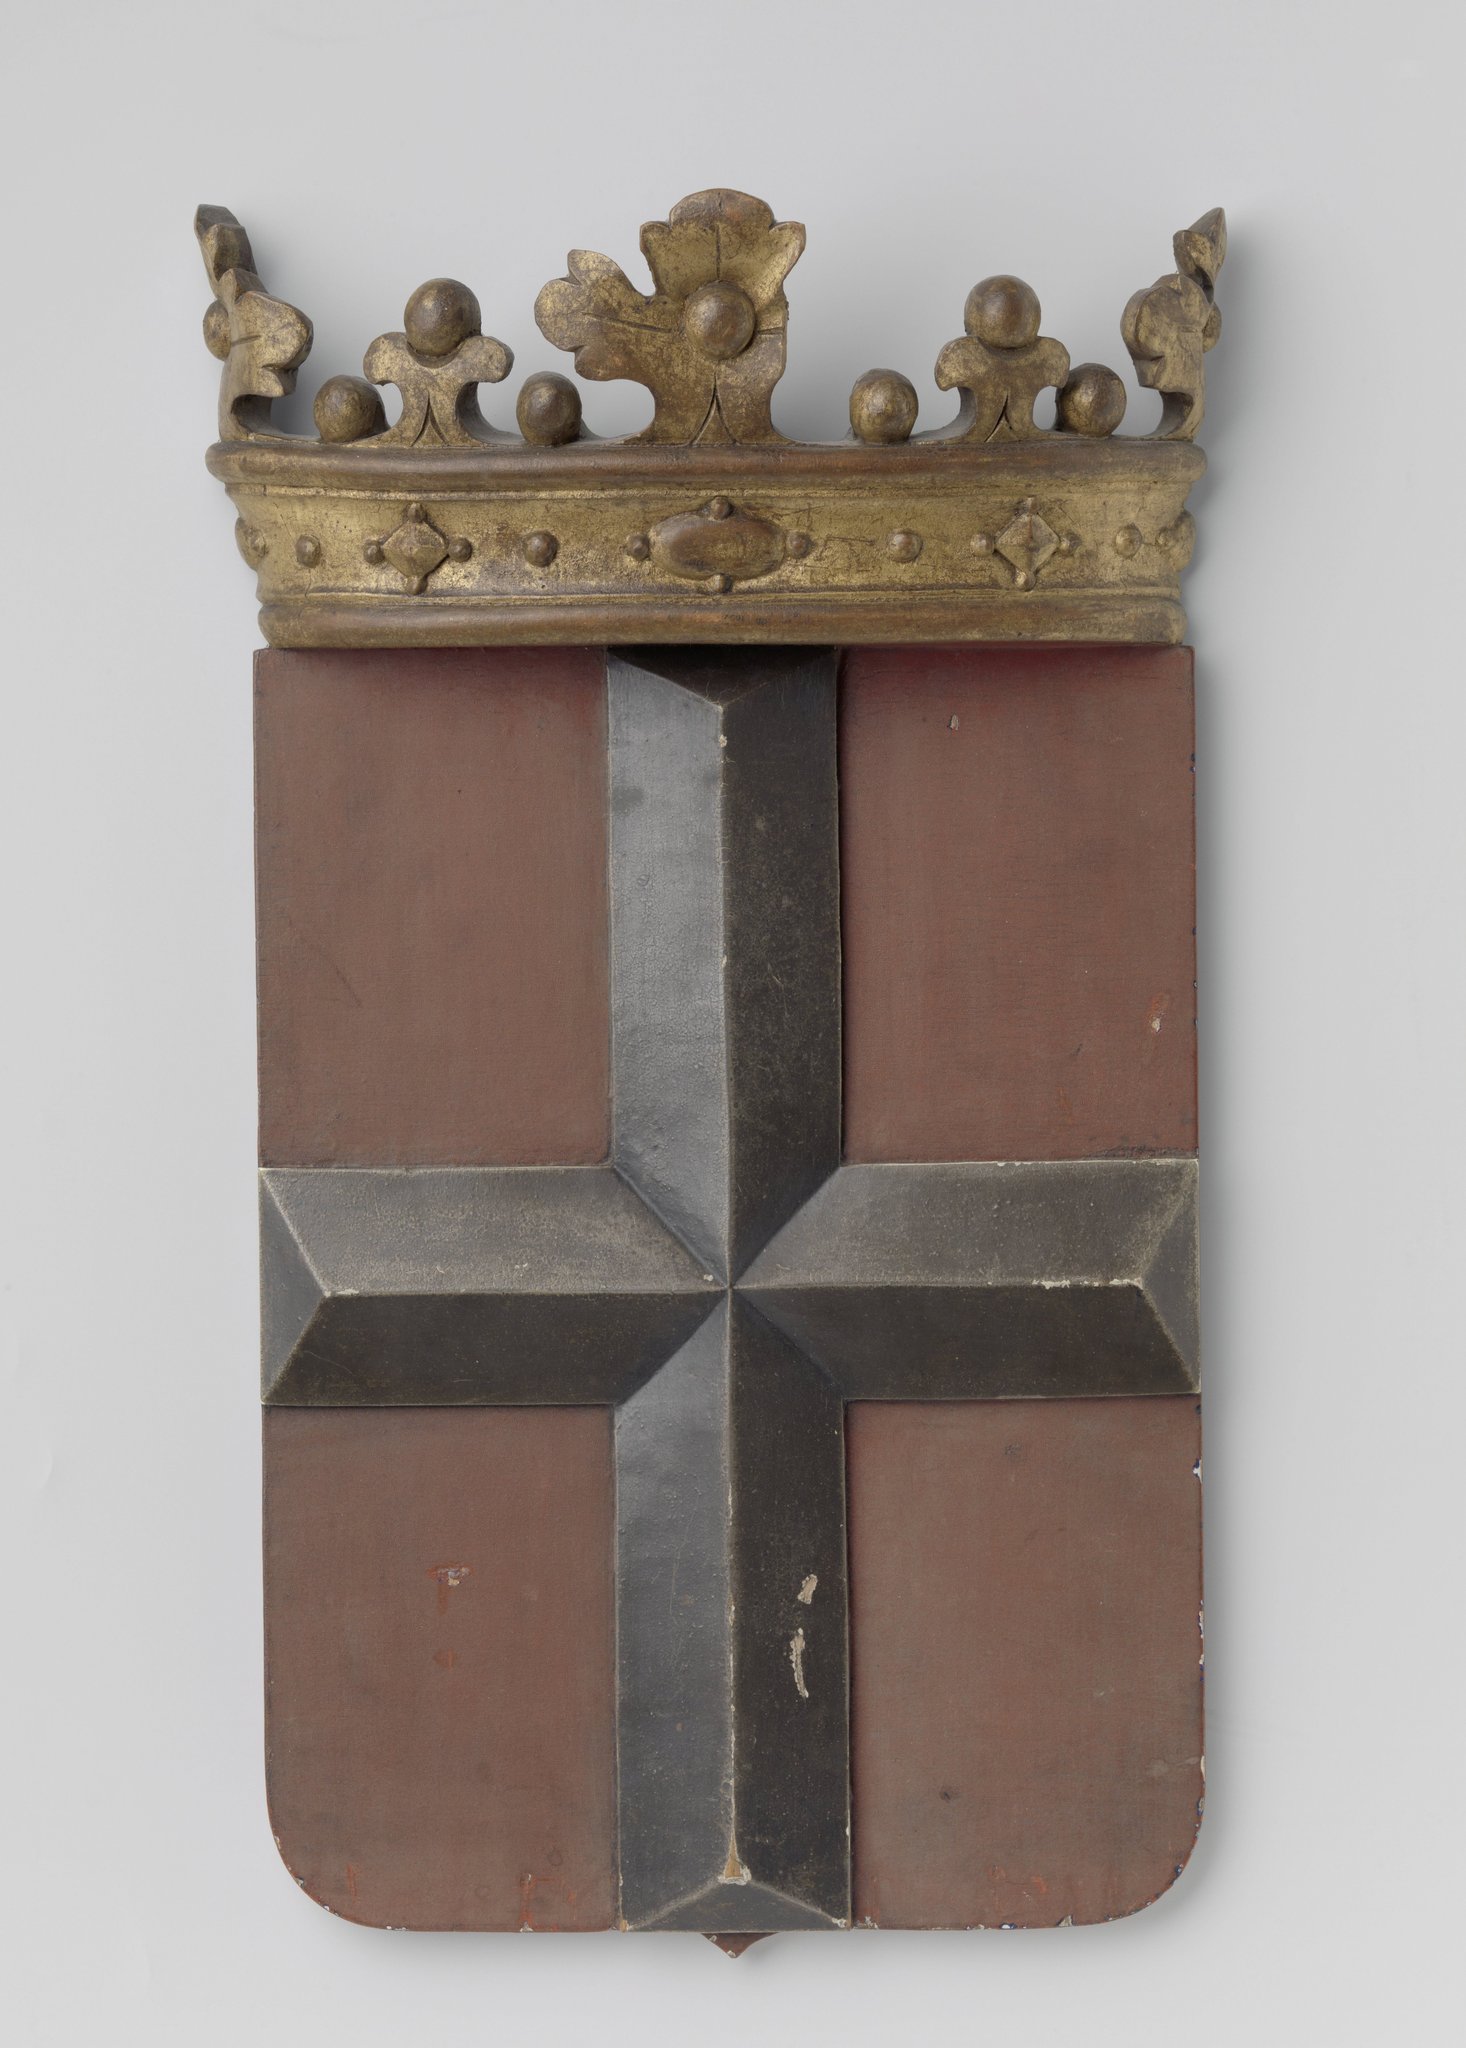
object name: shield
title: Het eerste kwartier van het wapen van Michiel Adriaenszoon de Ruyter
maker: Anonymous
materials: wood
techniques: polychromy, carving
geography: netherlands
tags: flushing, michiel adriaenszoon de ruyter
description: Arms of the De Ruyter family, made between 1676 and 1683. Michiel de Ruyter was a commoner by birth. In gratitude for his exploits against the Swedes, the king of Denmark ennobled the Dutch admiral in 1660. De Ruyter received a coat of arms of which the four quarters represented the Danish flag, a ship at sea, a gun and a horseman - a play on his name. The Spanish king awarded De Ruyter's son Engel a baronetcy in 1678. This added a heart-shaped shield with a lion to the family coat of arms.